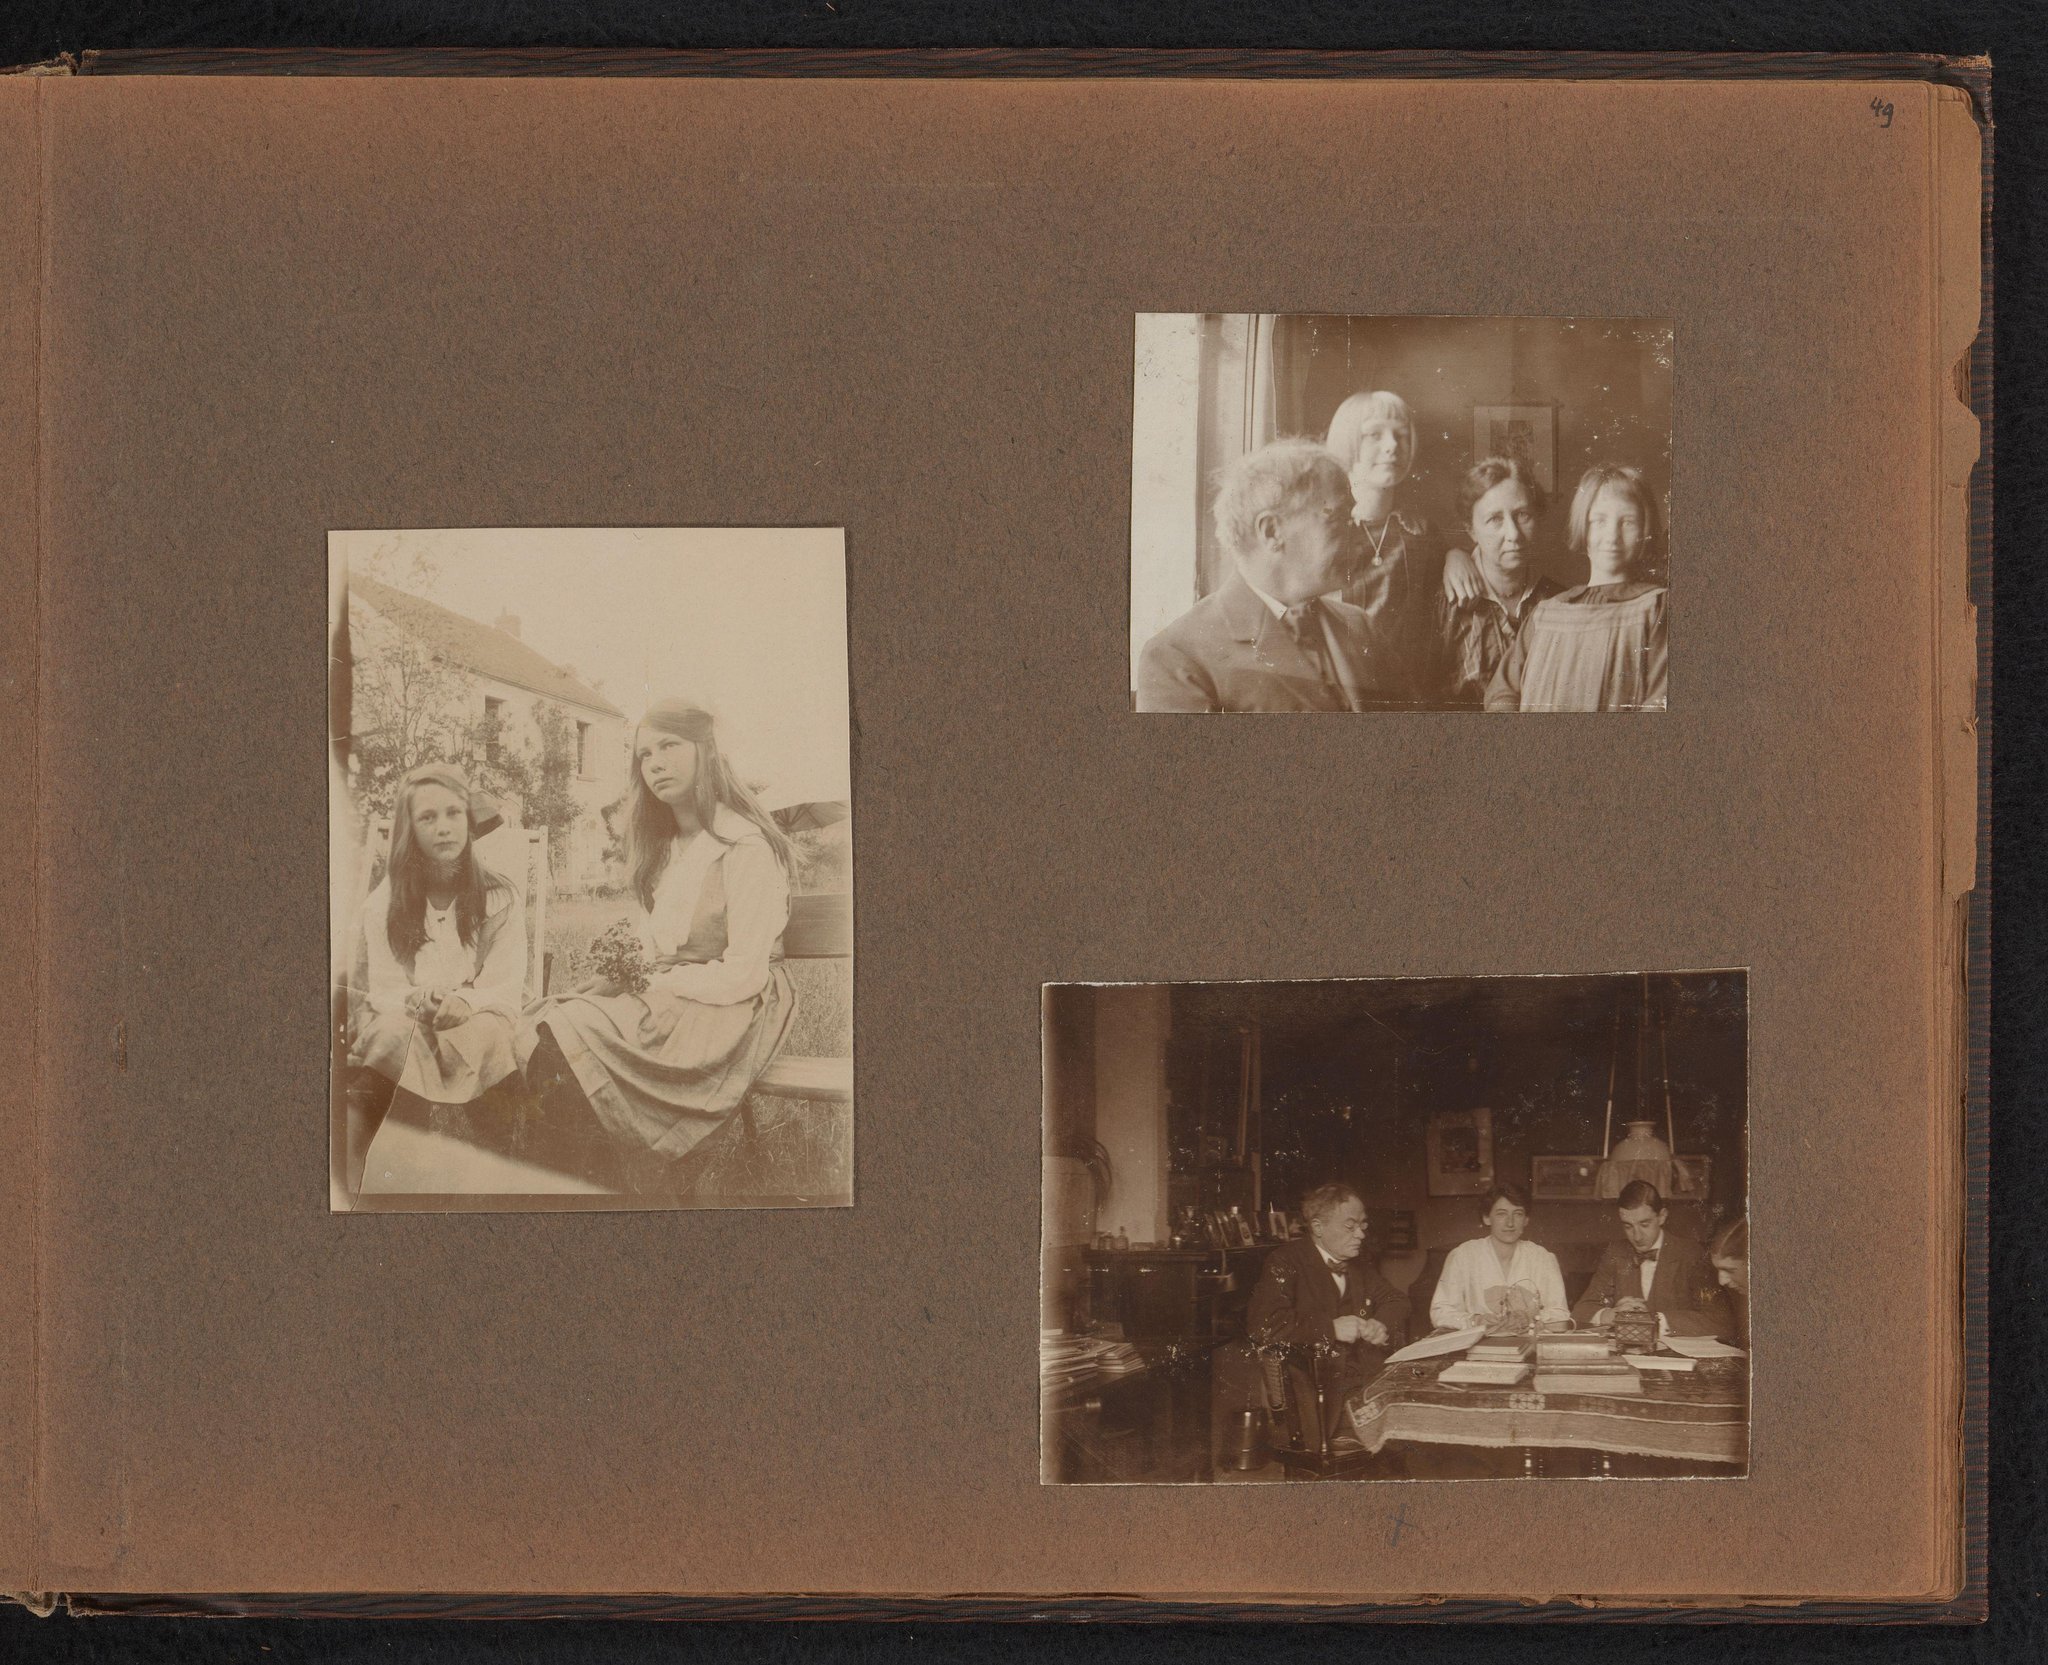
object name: album leaf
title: Bladzijde uit het fotoalbum van de familie Diepenbrock met 3 foto's van Alphons Diepenbrock en zijn omgeving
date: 1909-1920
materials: cardboard, photographic support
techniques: photography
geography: netherlands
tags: amsterdam, alphons diepenbrock, jonkvrouw wilhelmina elisabeth petronella cornelia de jong van beek en donk, netherlands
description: Bruin albumblad 49 van familiealbum van Alphons Diepenbrock.